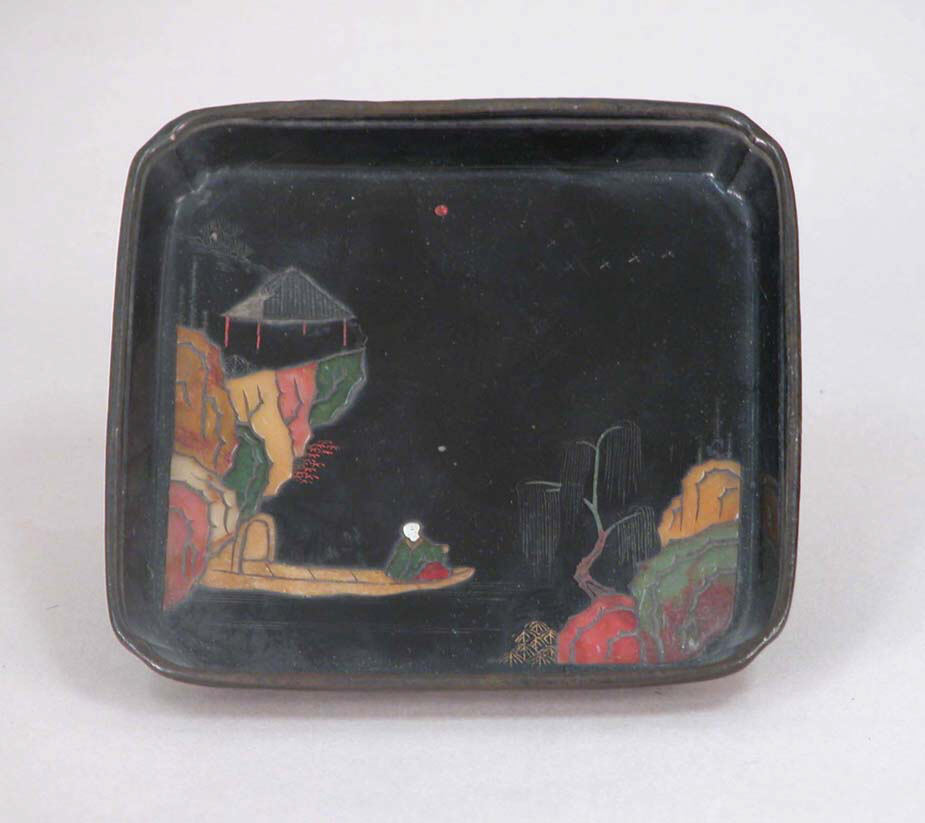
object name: tray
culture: chinese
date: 1601-1700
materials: lacquer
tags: boats